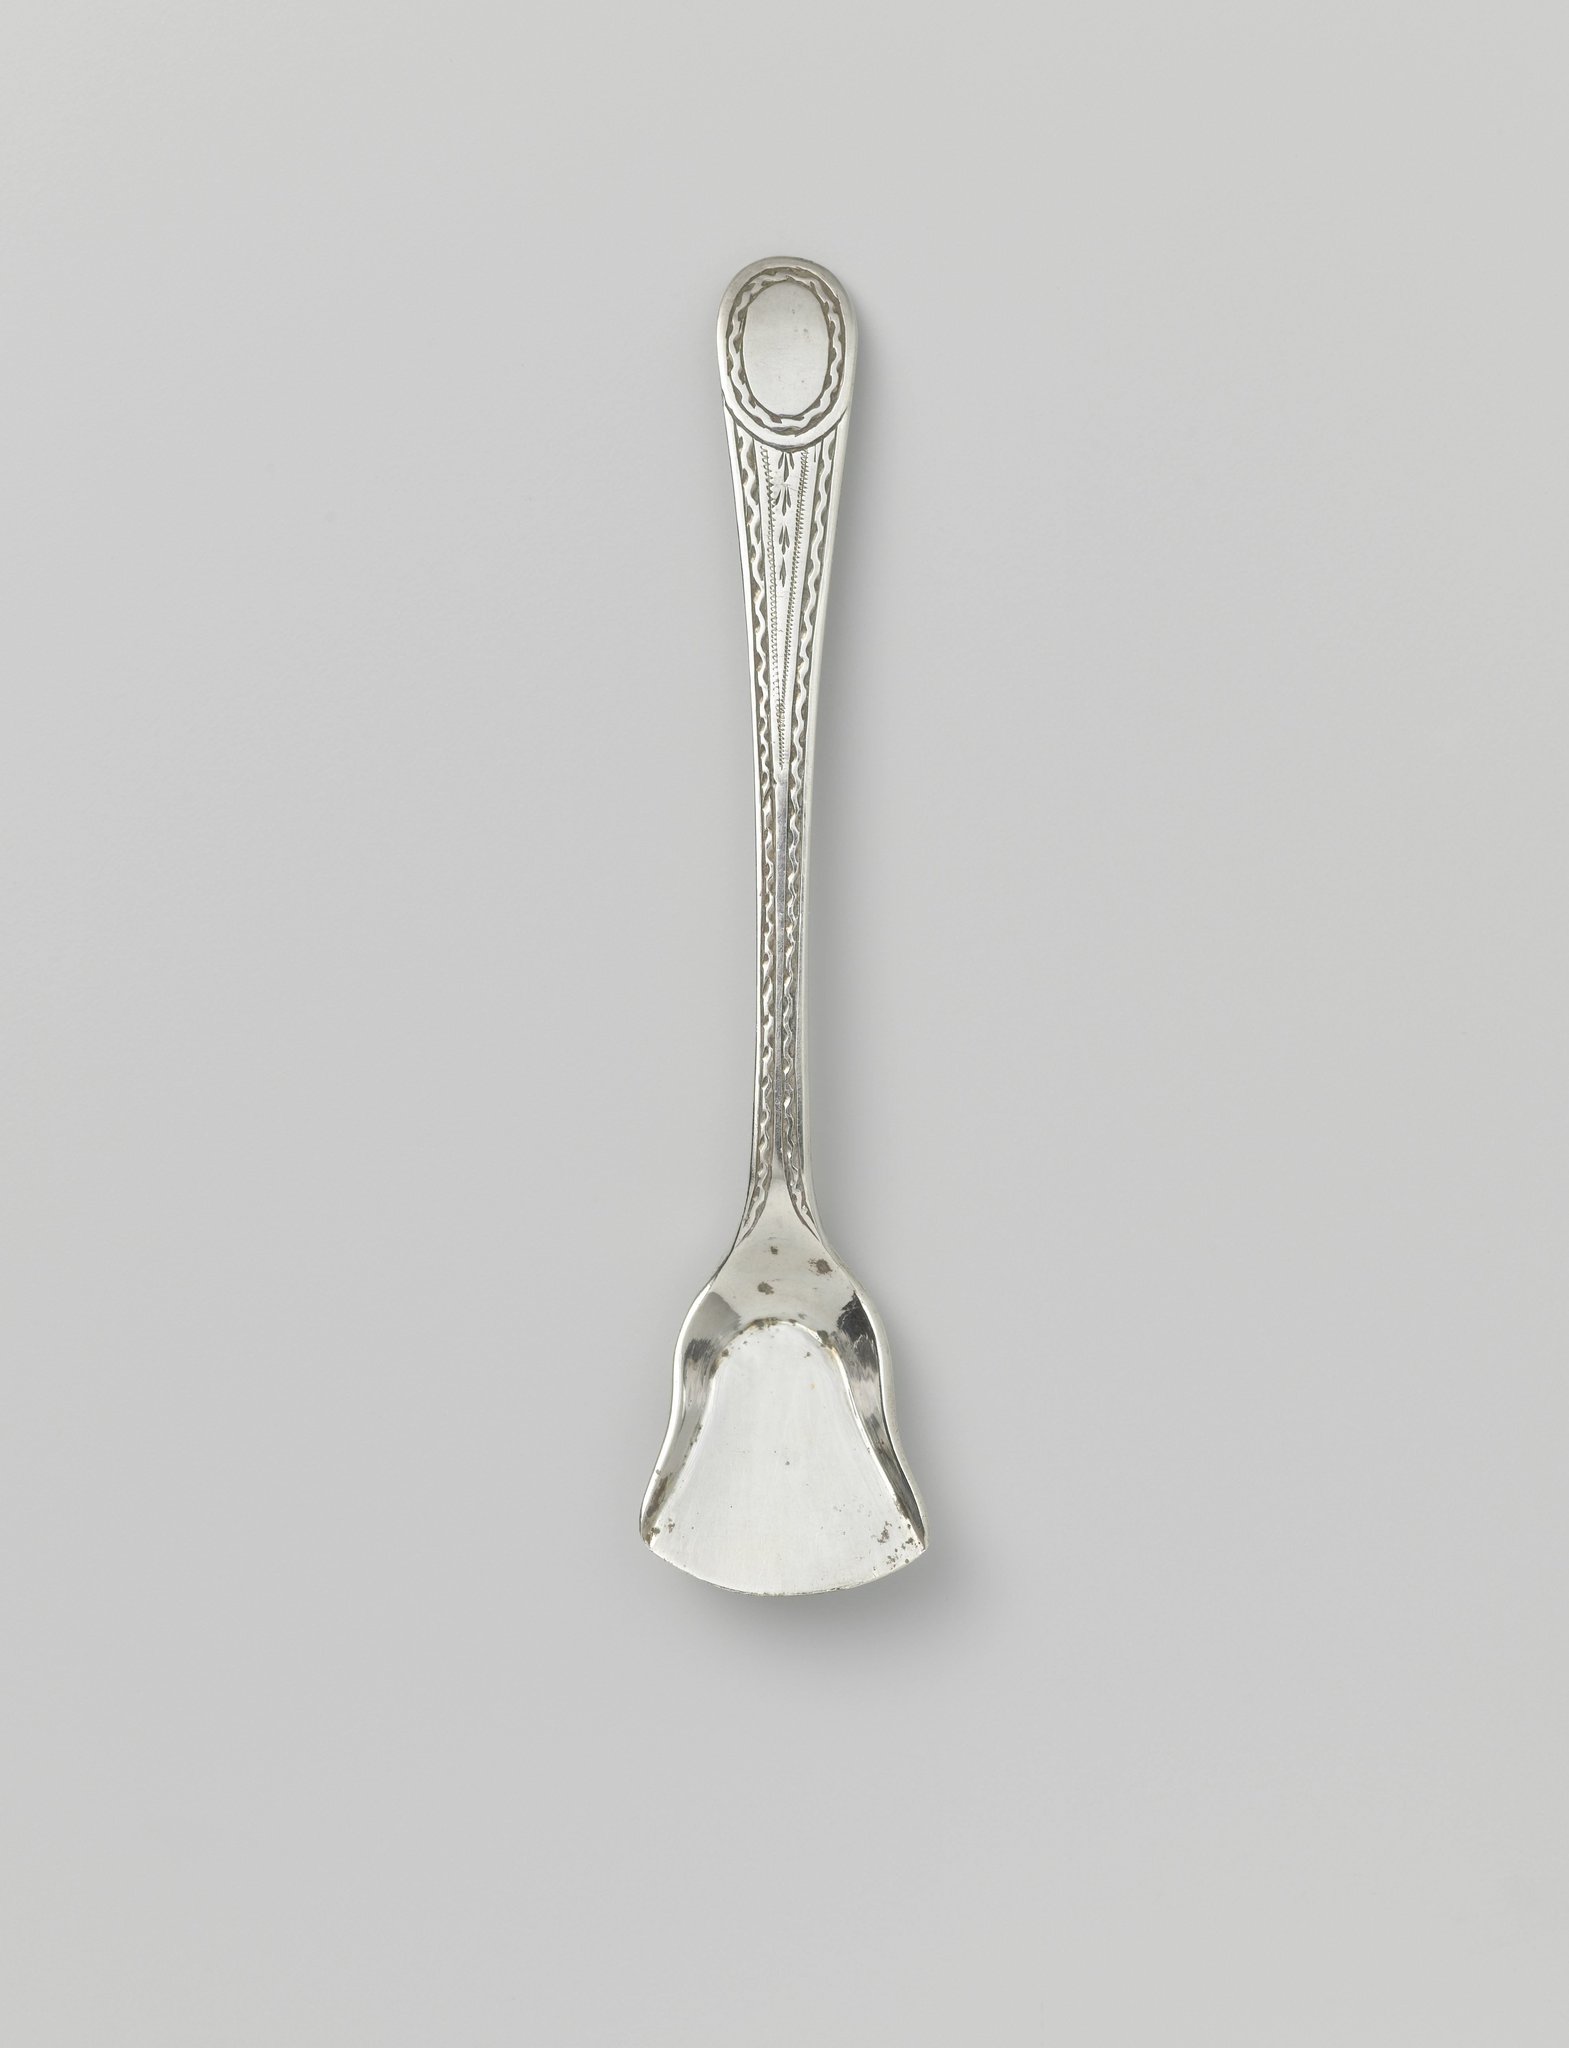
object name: salt spoon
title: Zoutlepel, schepvormig met gegraveerde steel en ovaal op de punt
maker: jan pieter barbier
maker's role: jeweler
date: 1400-1950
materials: silver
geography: the hague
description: Vier zoutlepeltjes van zilver. Schepvormig met gegraveerde steeltjes, op de punt een ovaal. Merk: Den Haag (onleesbaar), meesterteken I.P.B. (toegeschreven aan Jan Pieter Barbie(r)). Genummerd A t/m D.